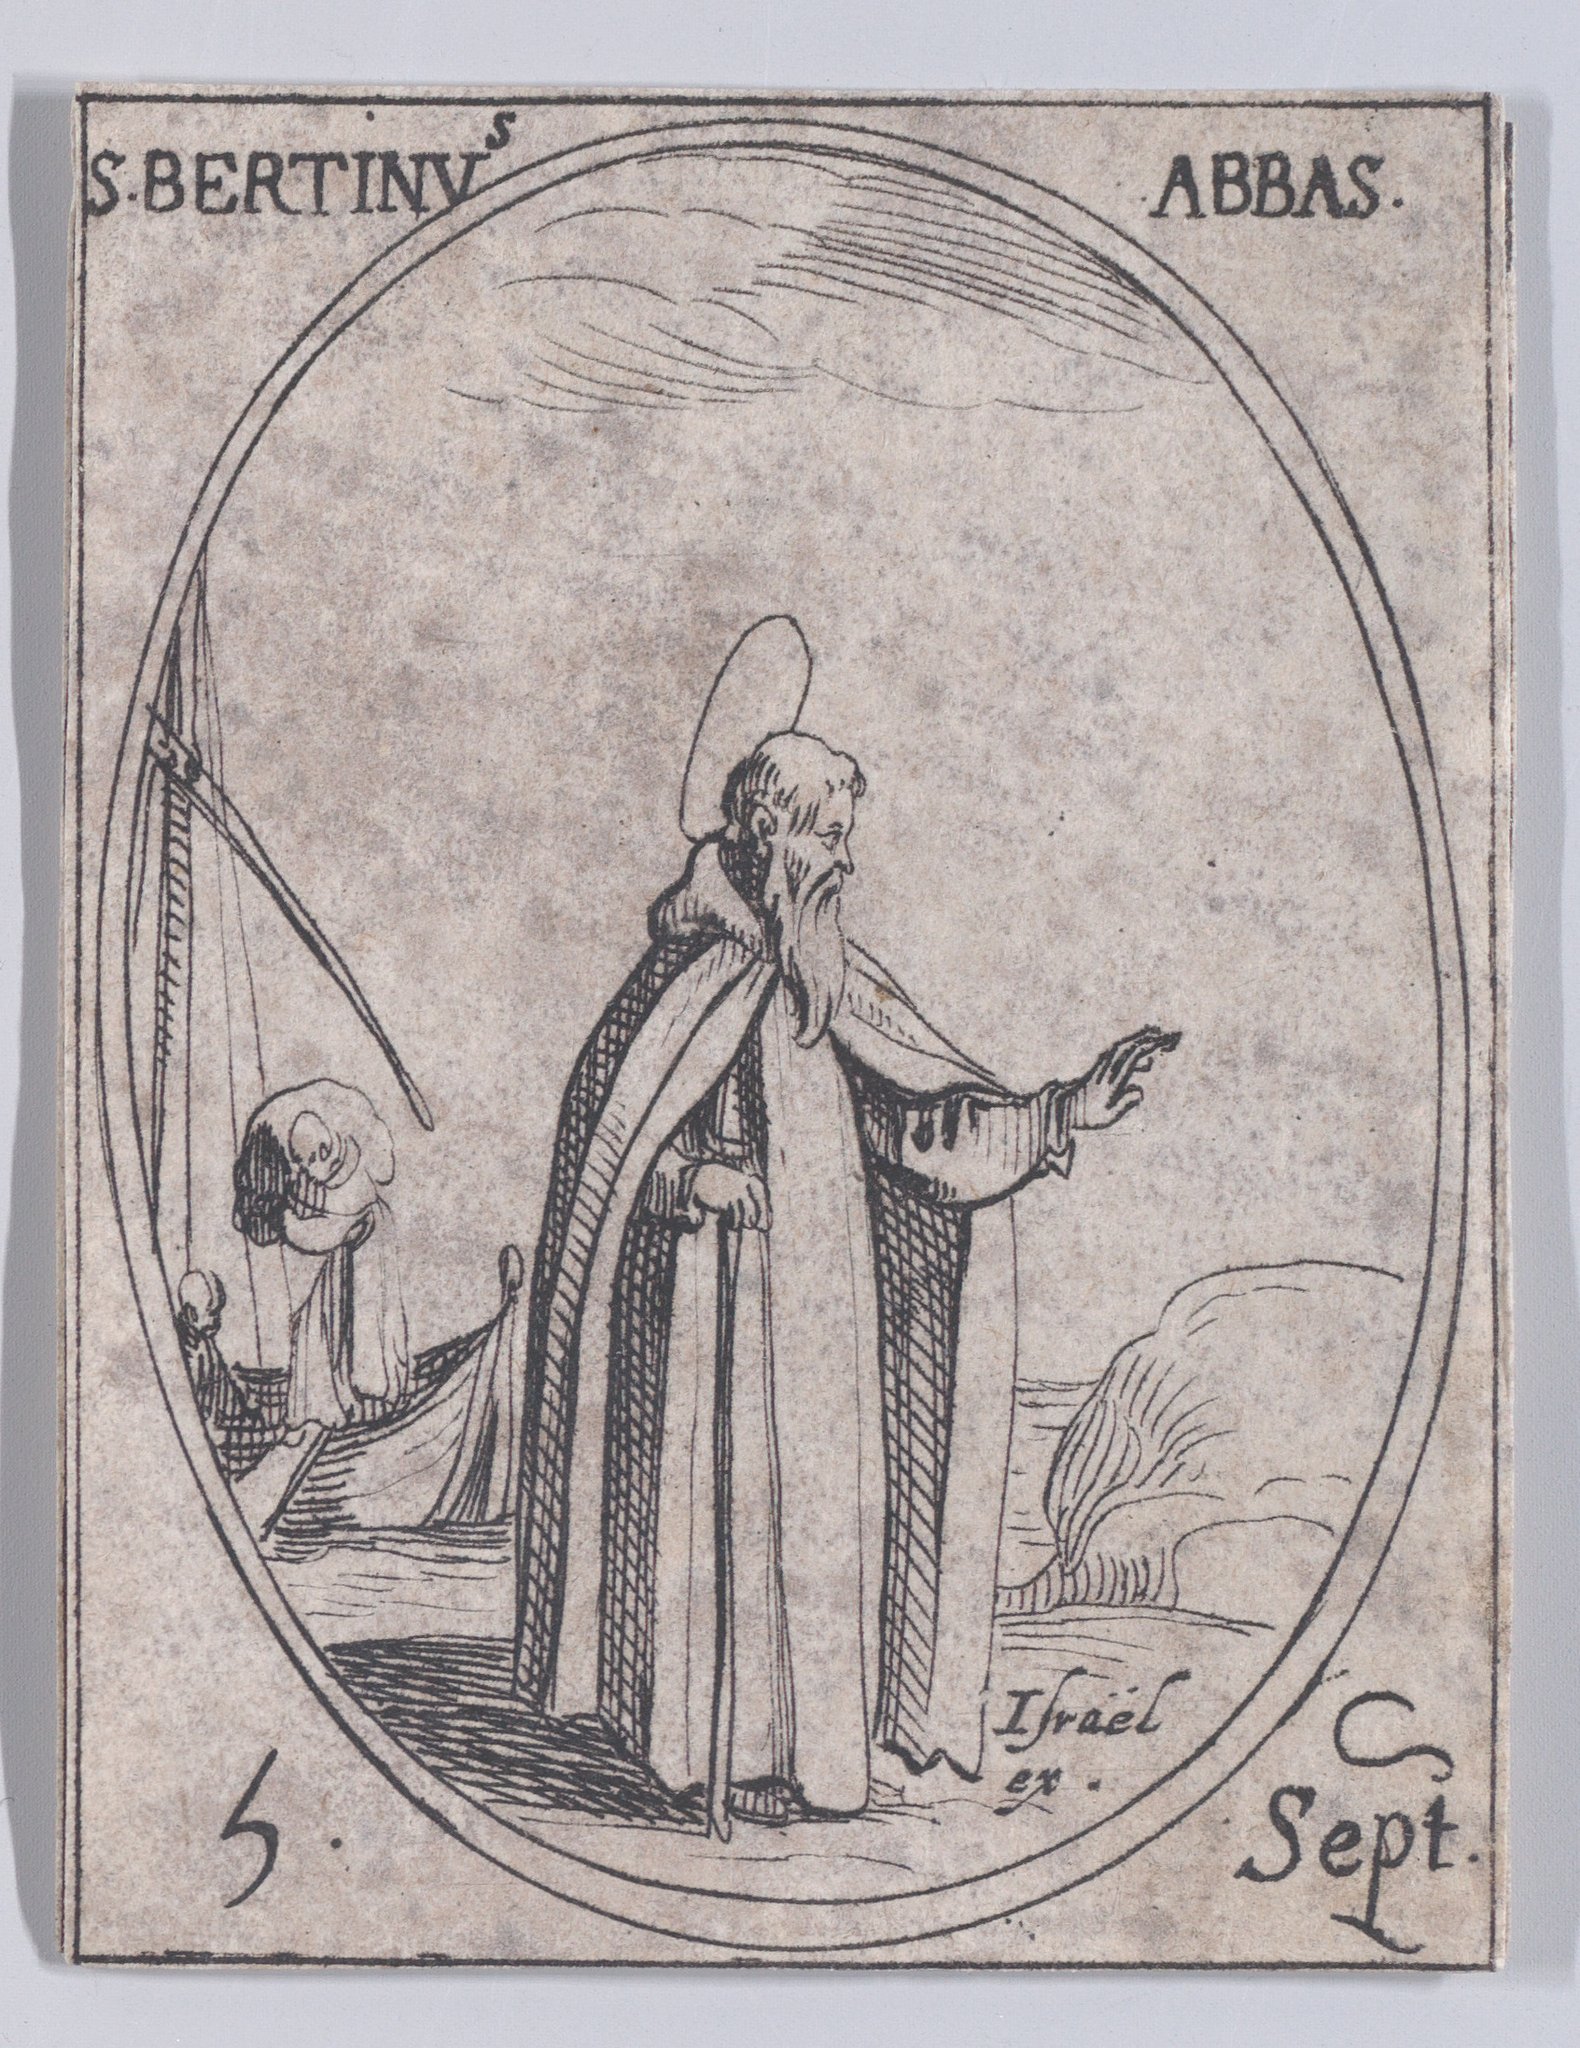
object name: print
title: S. Bertin, abbé (St. Bertinus, Abbot), September 5th, from "Les Images De Tous Les Saincts et Saintes de L'Année" (Images of All of the Saints and Religious Events of the Year)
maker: jacques callot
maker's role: artist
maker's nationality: french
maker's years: 1592-1635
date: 1636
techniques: etching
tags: men,saints